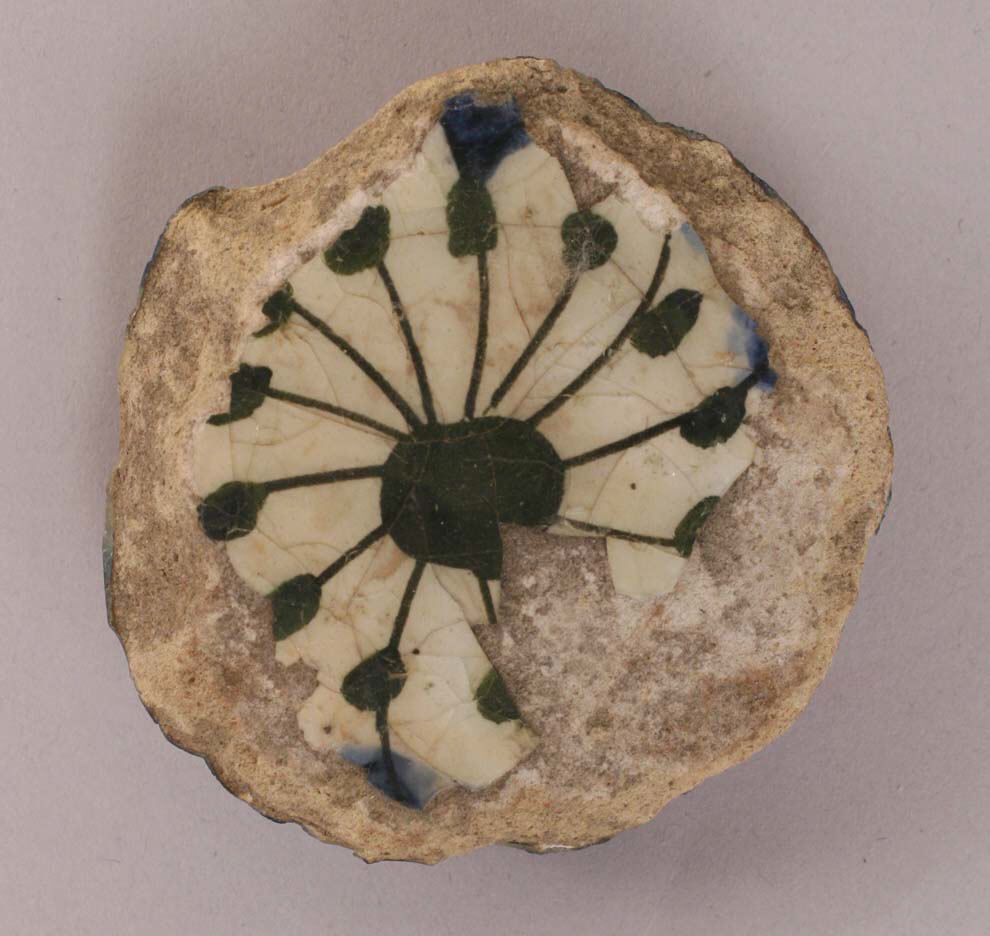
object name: fragment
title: Fragment of a Bowl or Cup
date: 1201-1600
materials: glaze, stonepaste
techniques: painting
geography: egypt